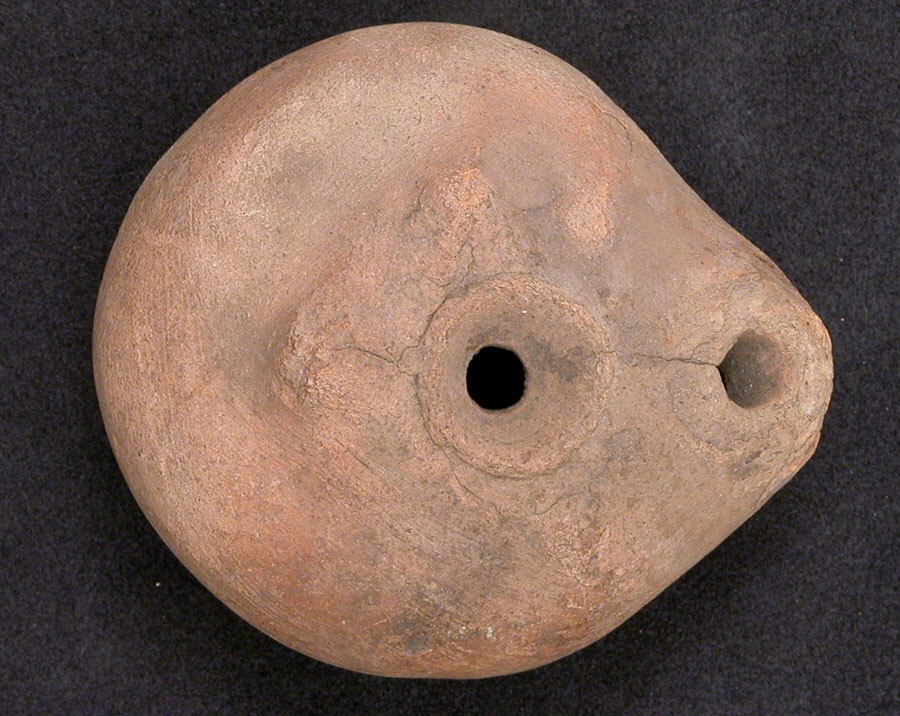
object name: lamp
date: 101-700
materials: earthenware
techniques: molding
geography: egypt